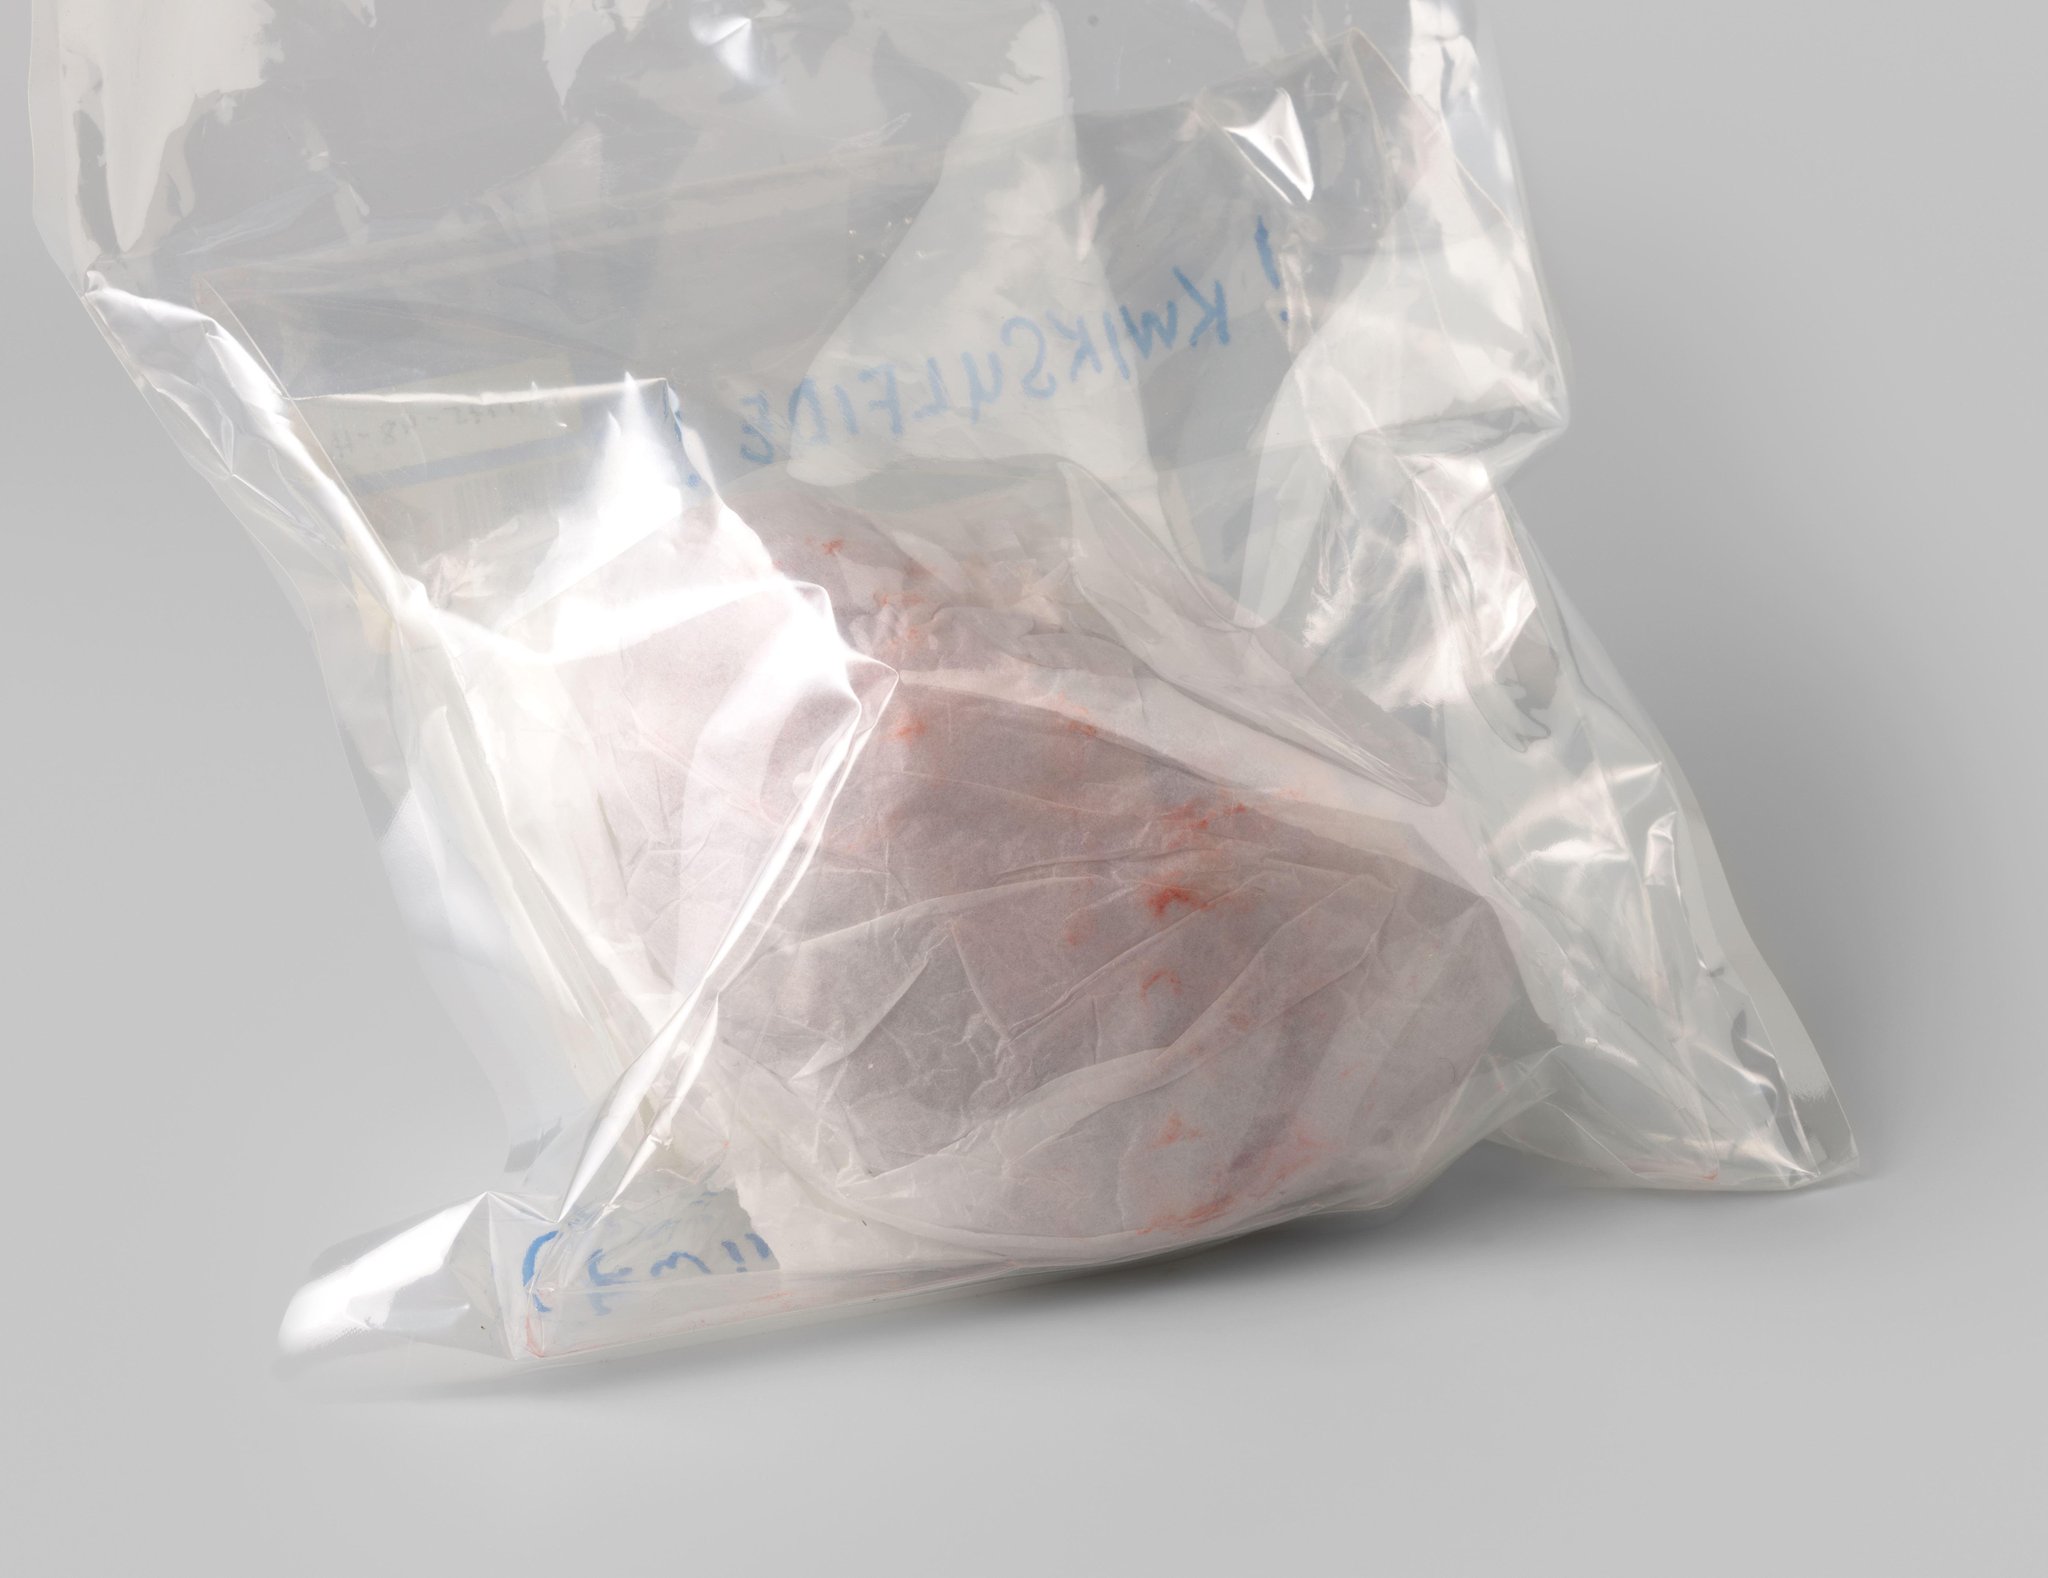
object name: pigment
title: Kwiksulfide uit het wrak van de Oost-Indiëvaarder Hollandia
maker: Anonymous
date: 1700-1743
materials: mineral, pigment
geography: netherlands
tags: verenigde oostindische compagnie, hollandia (schip), annet